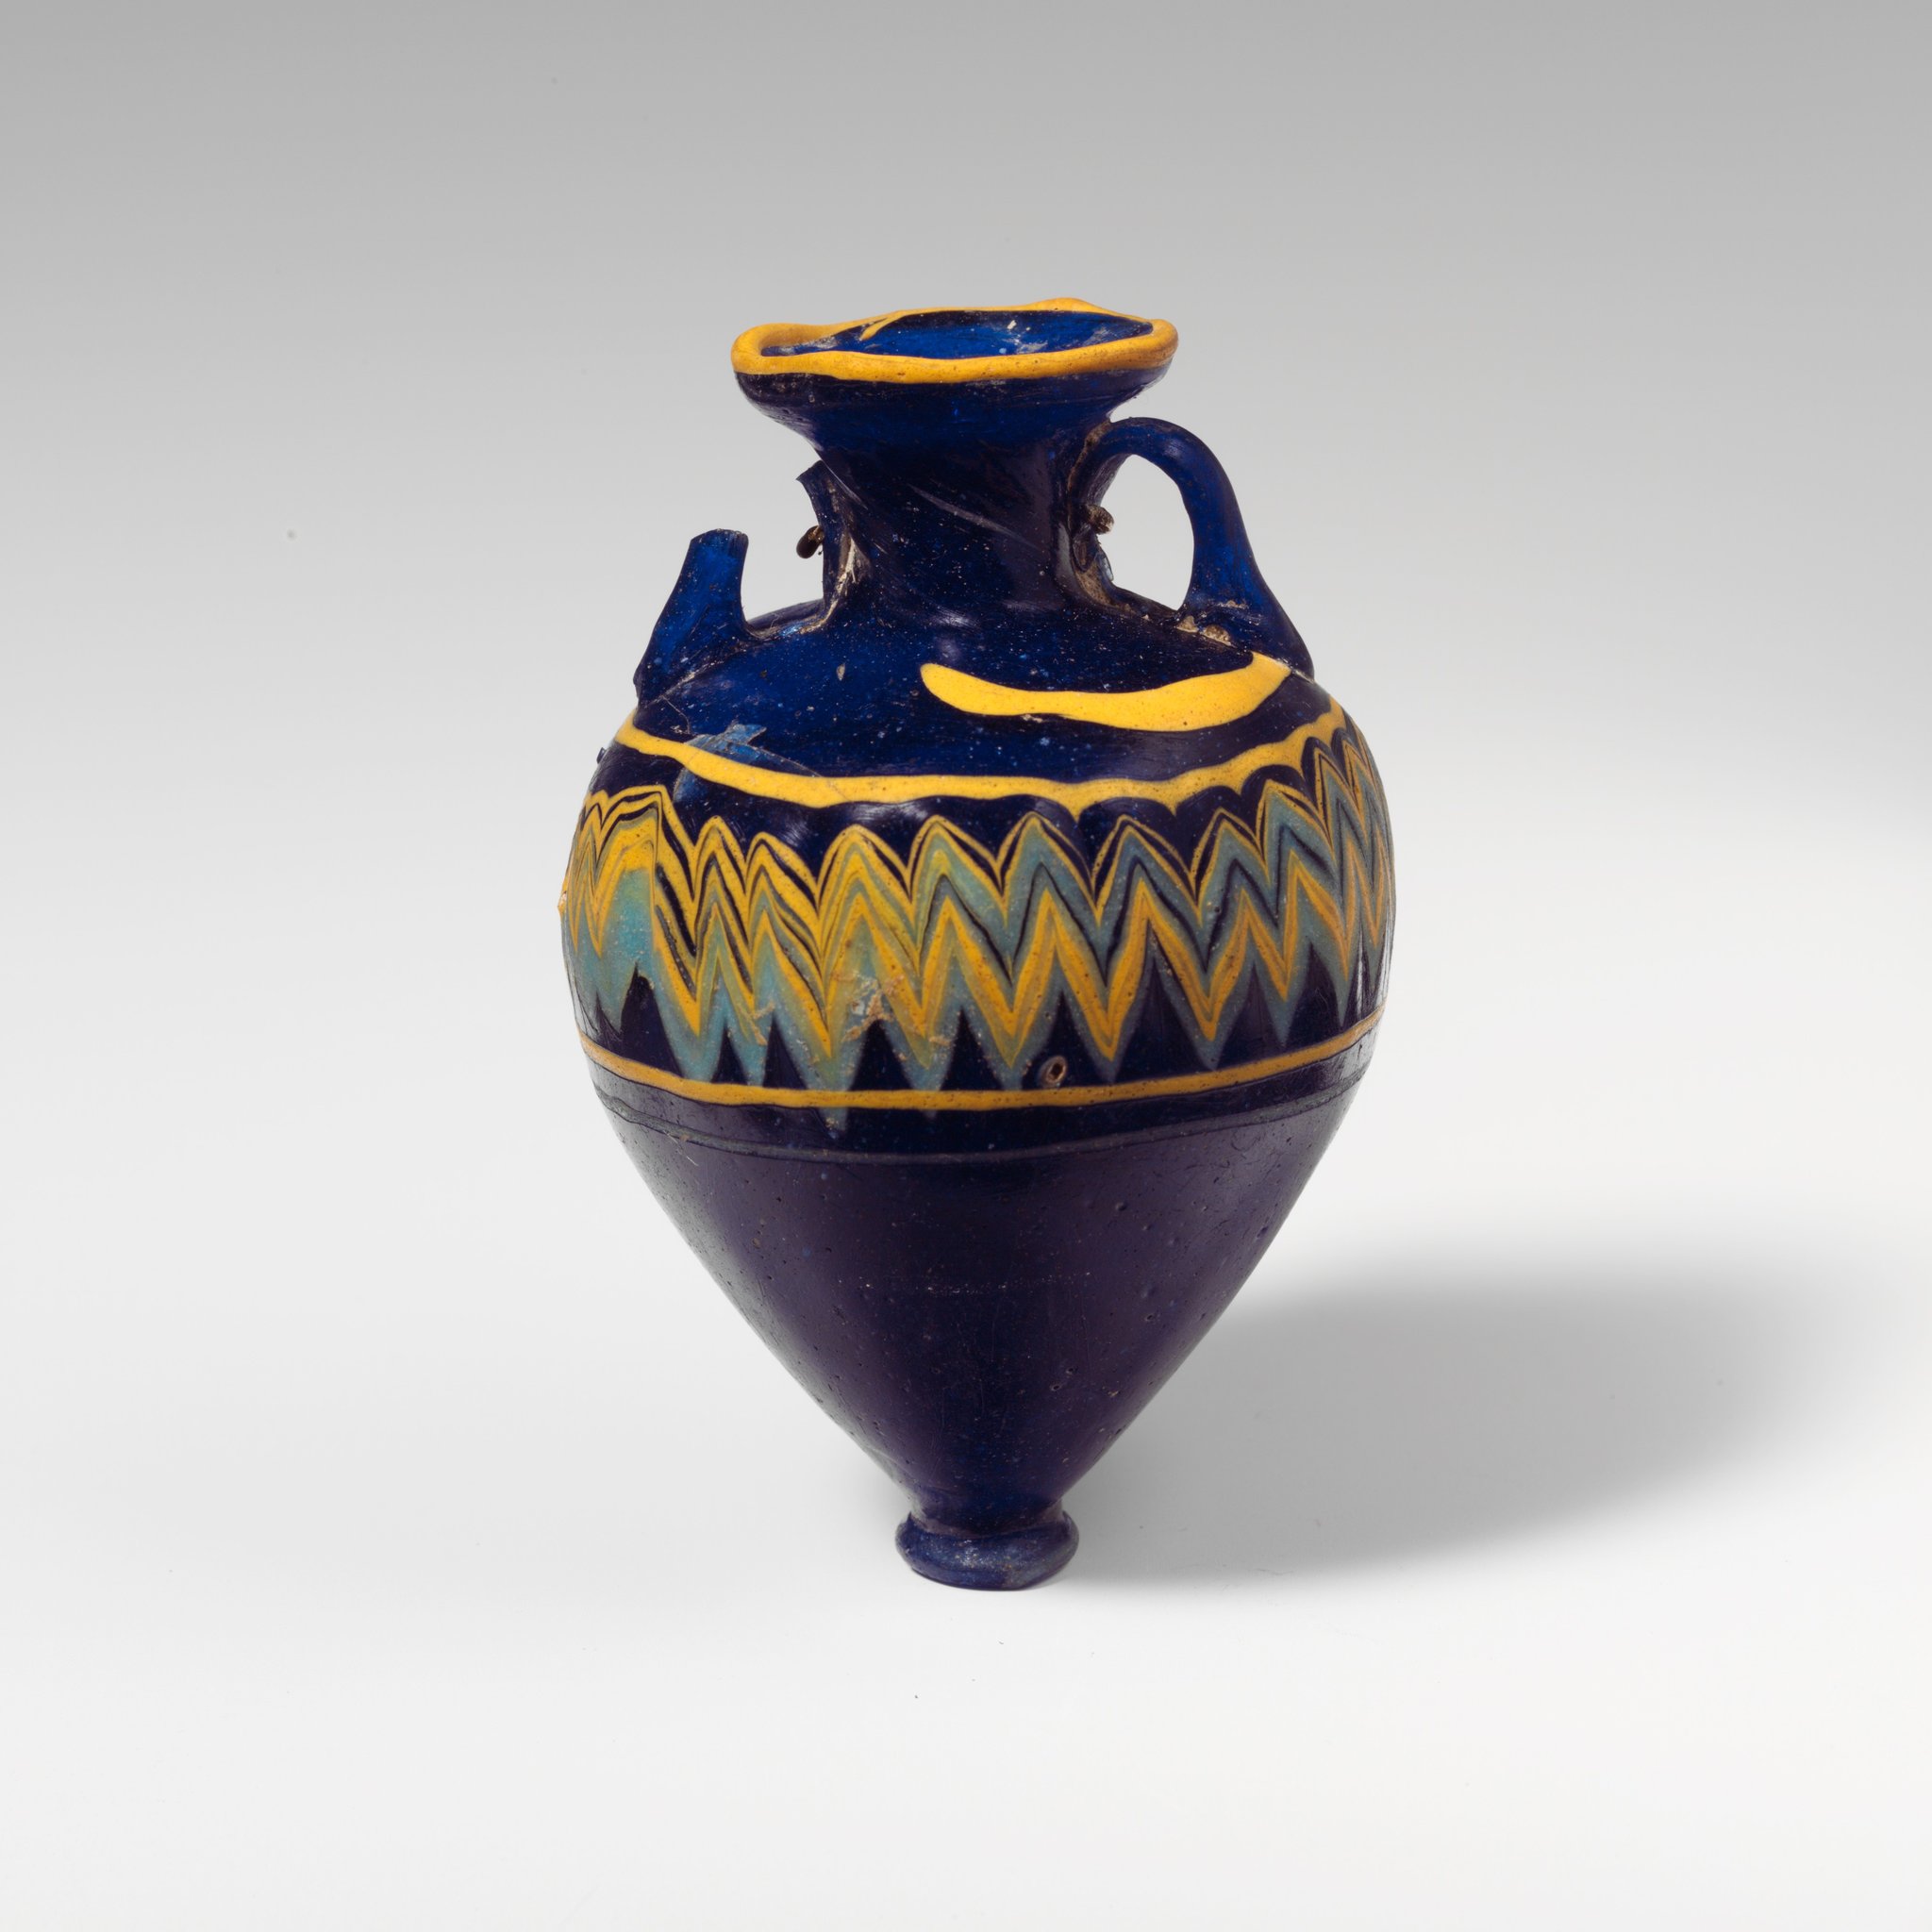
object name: amphoriskos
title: Glass amphoriskos (perfume bottle)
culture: greek, eastern mediterranean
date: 534-401 BCE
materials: glass